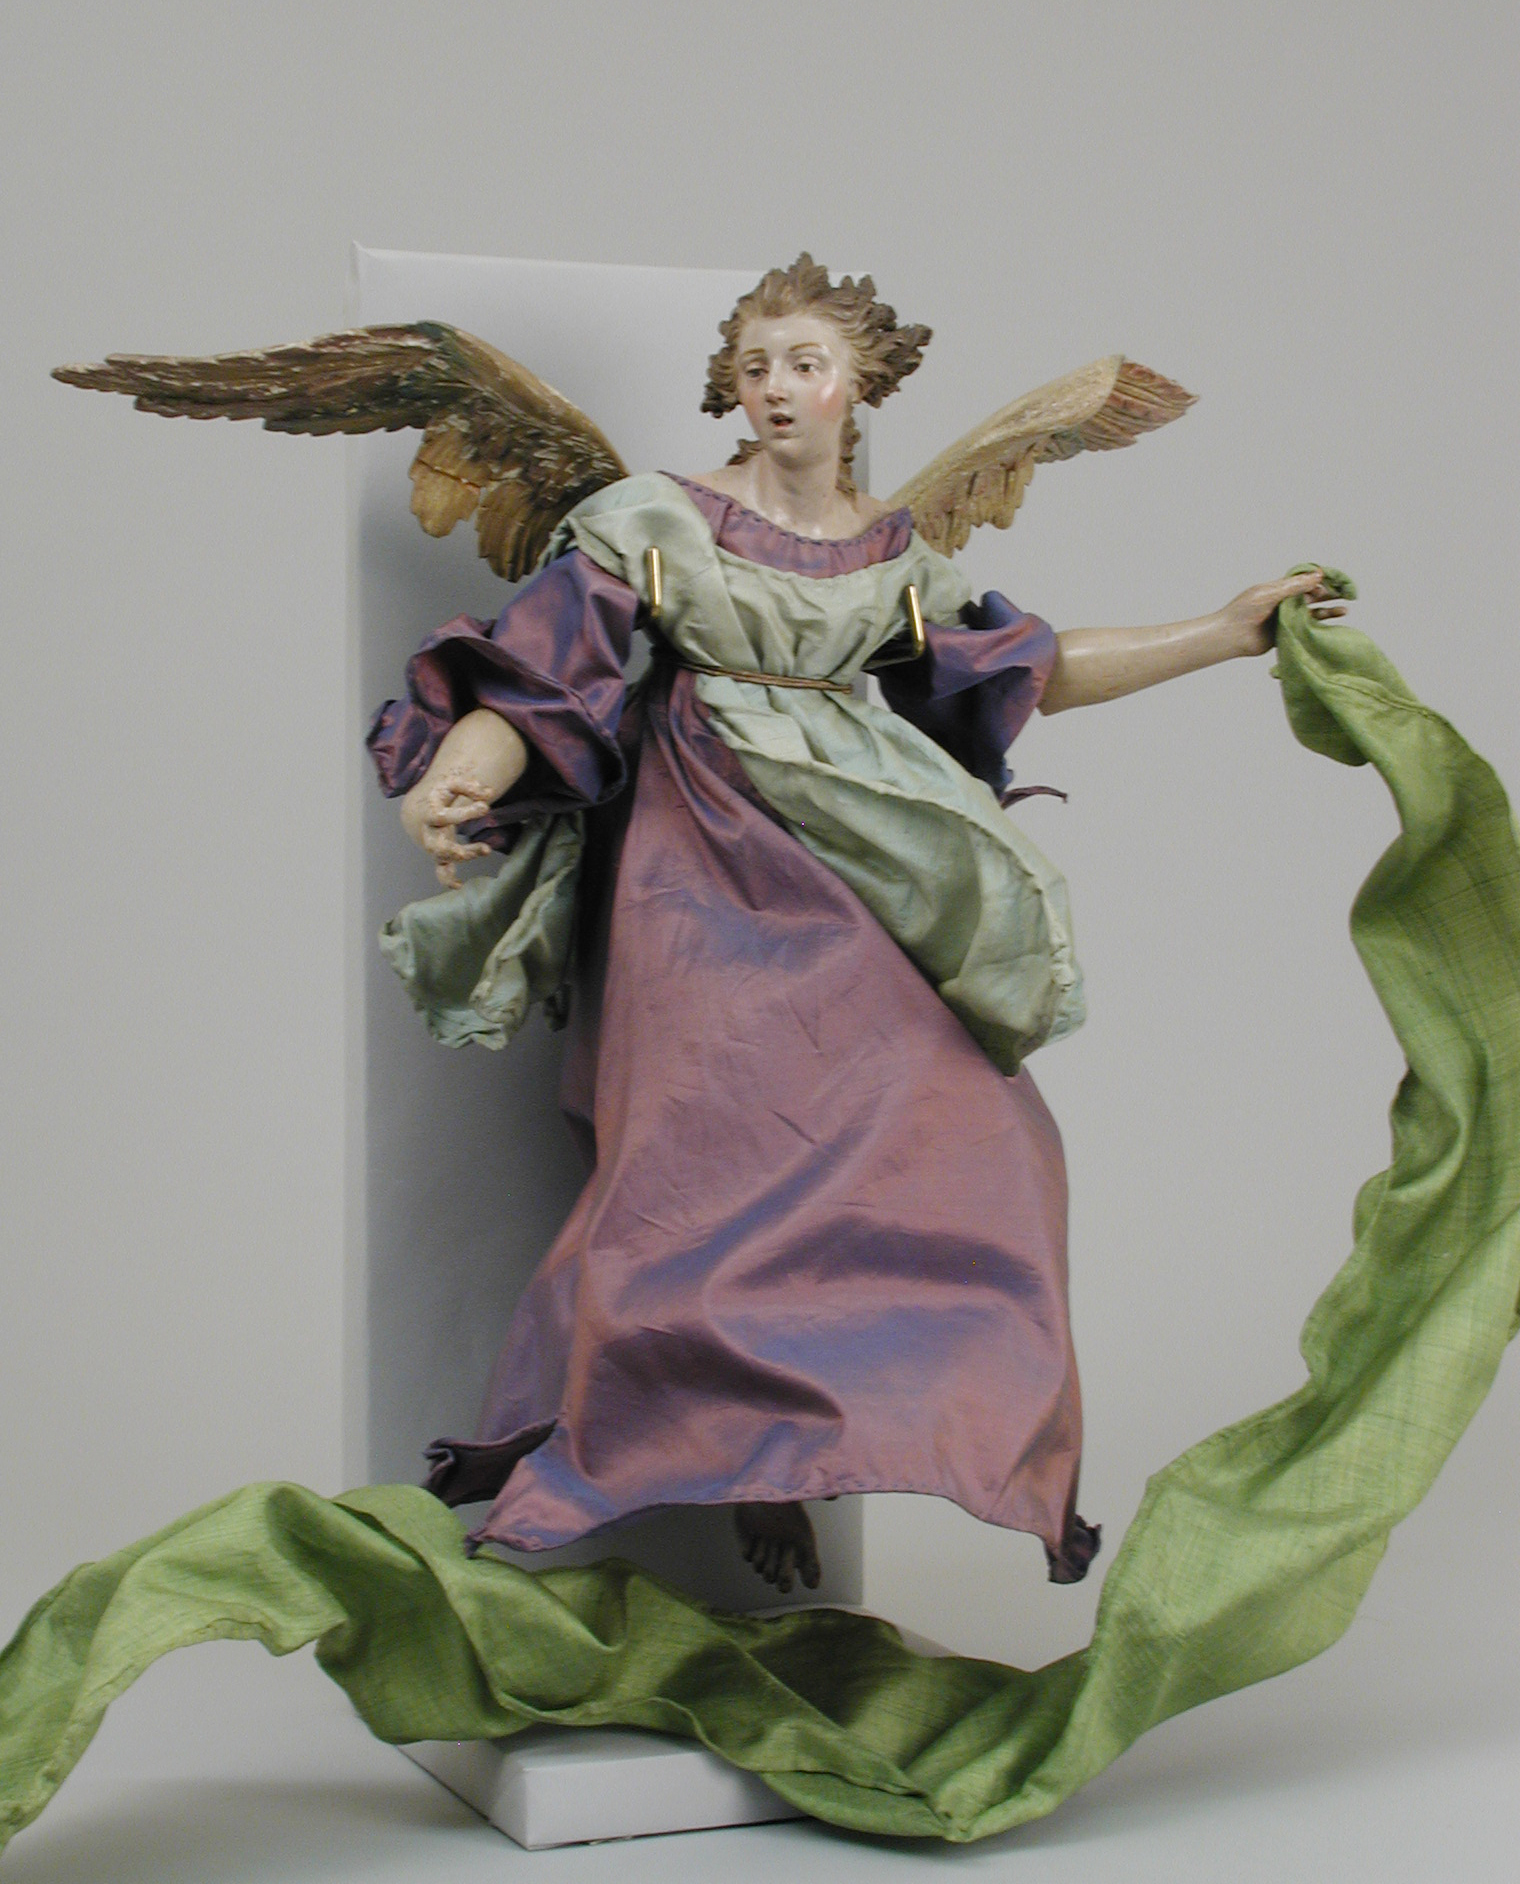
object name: crèche figure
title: Angel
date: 1751-1800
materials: terracotta, fiber, metal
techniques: polychrome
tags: angels